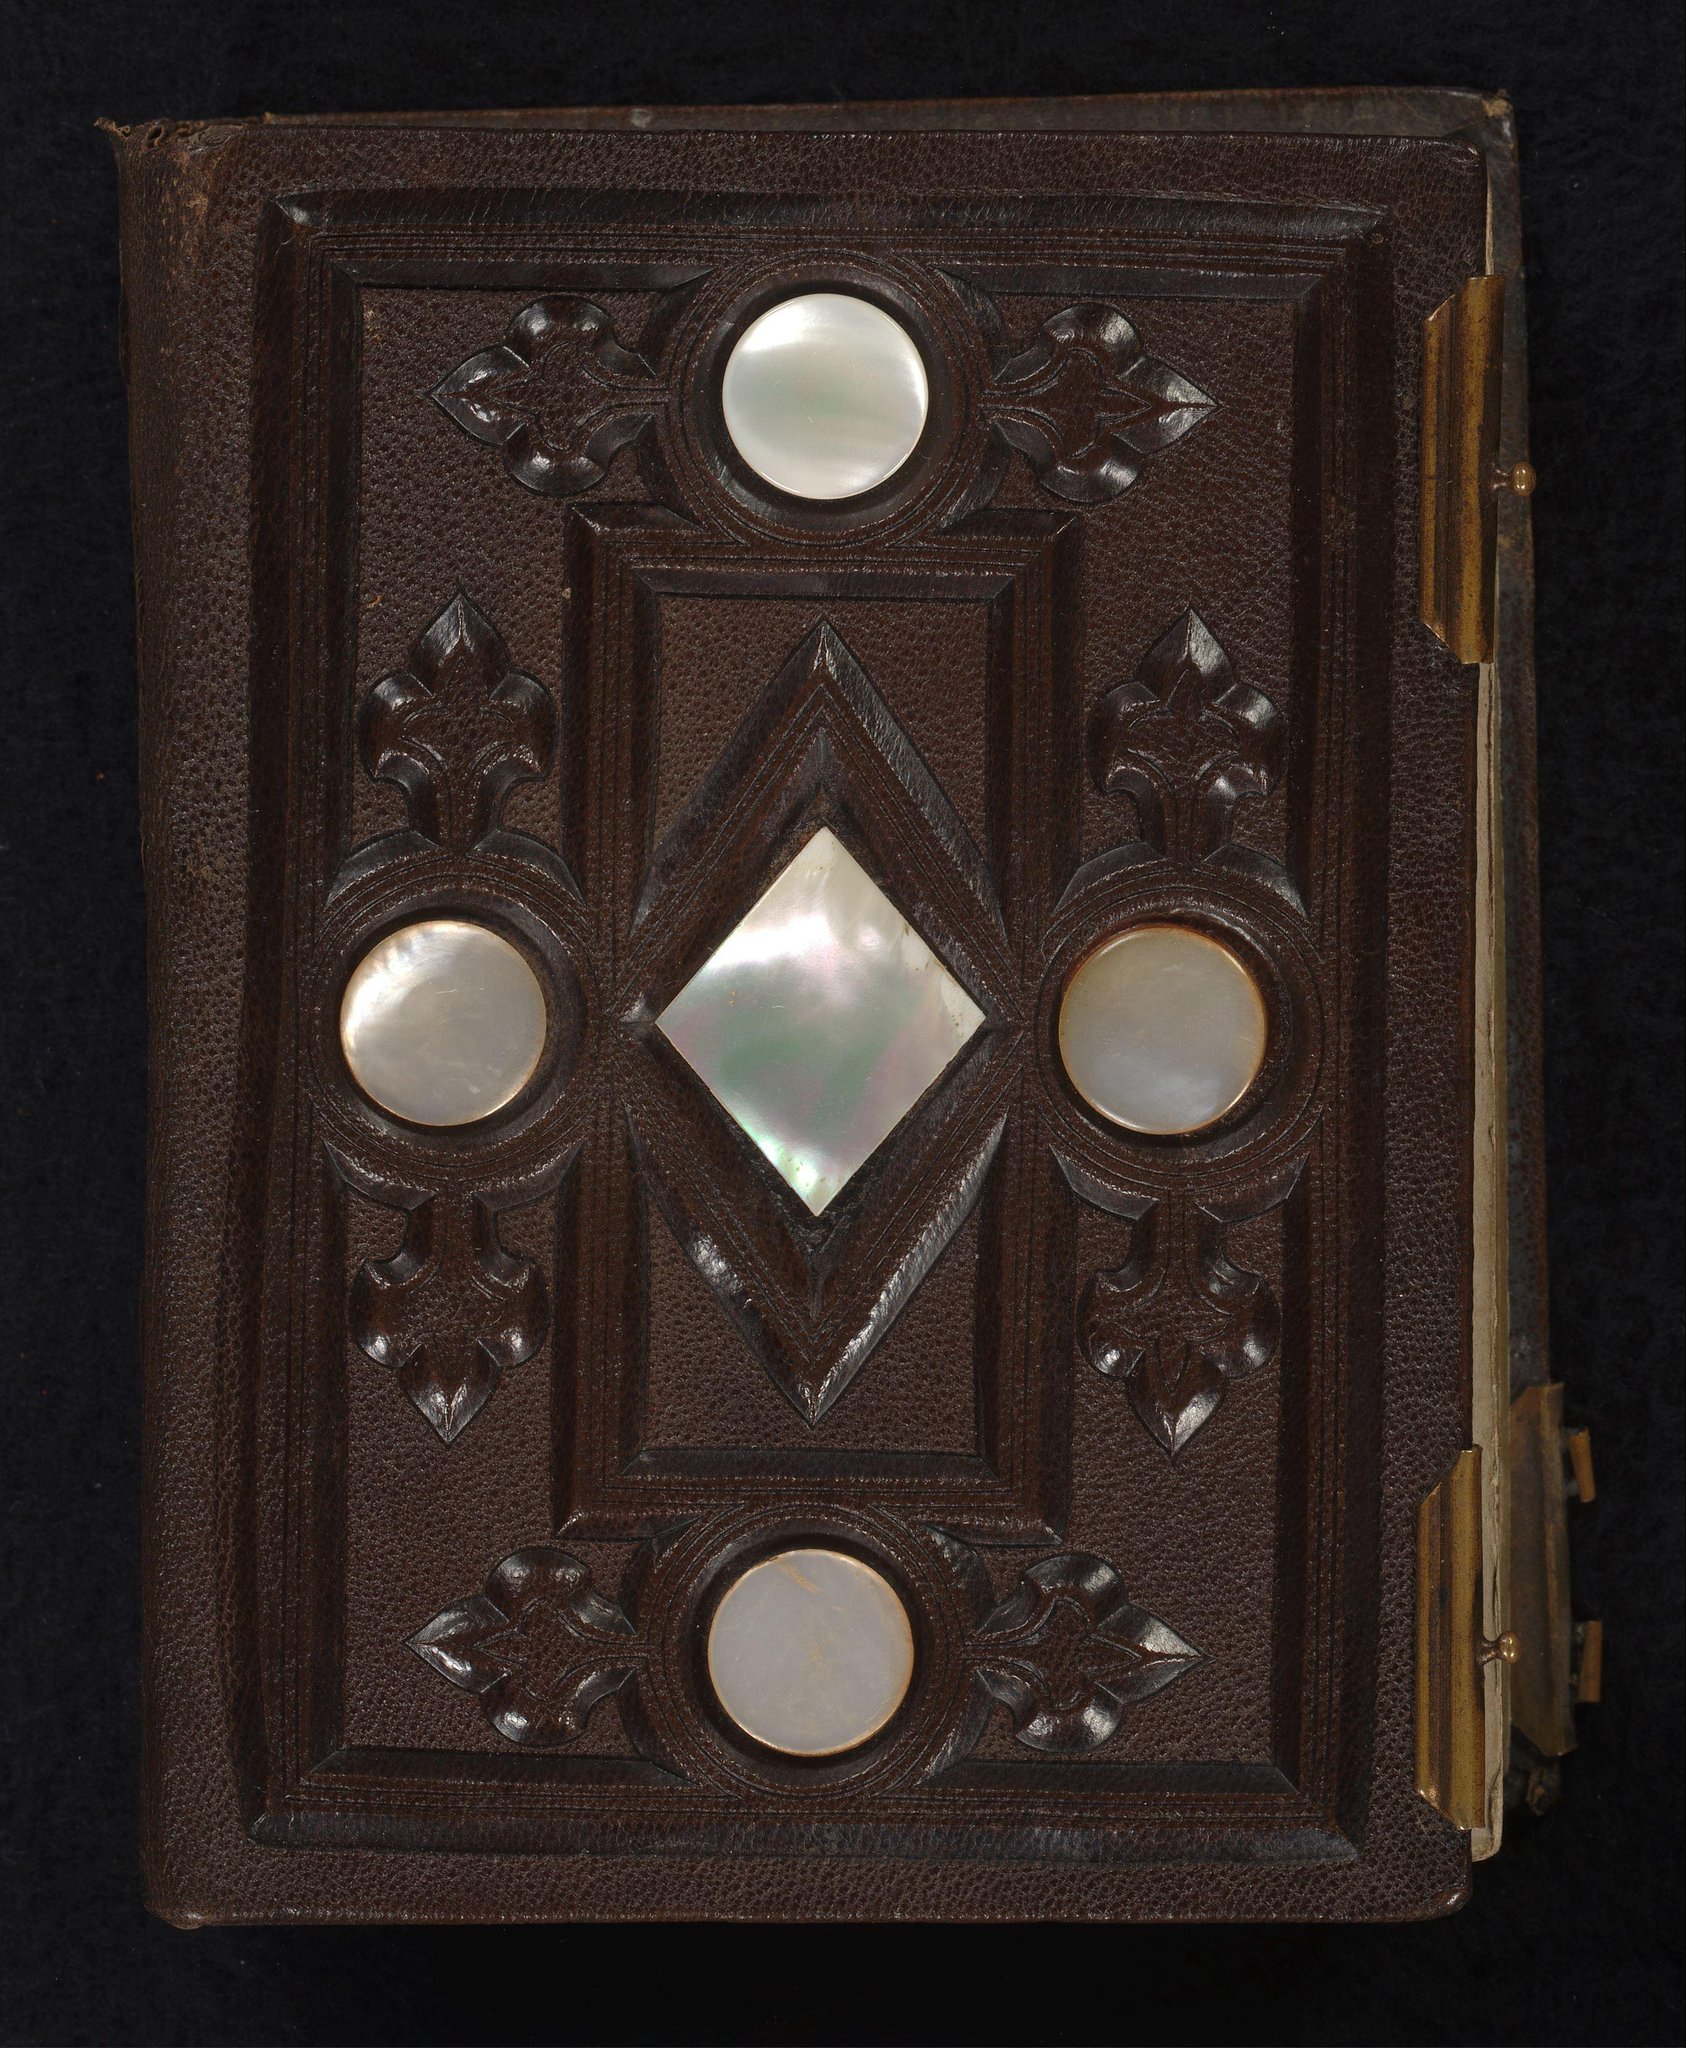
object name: photograph album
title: Engels en Schots fotoalbum met 36 foto's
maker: Anonymous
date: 1860-1900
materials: cardboard, leather, metal, mother of pearl, paper, photographic support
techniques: albumen print, ferrotyping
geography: united kingdom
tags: historical persons - bb - woman, child, historical persons, villa, united kingdom, glasgow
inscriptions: collector's mark: ‘DIENST/ VERSPREIDE/ RIJKSKOLLEKTIES/ (...) A 757’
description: Fotoalbum met in totaal 36 foto's op 48 pagina's. Het album bevat 35 cartes-de-visite en een ferrotypie in met gouden lijnen omkaderde passe-partouts. Iedere pagina bevat 1 passe-partout, maar niet alle passe-partouts in het album zijn gevuld. Afgebeeld zijn portretten van onbekende mannen, vrouwen en kinderen en een gezicht op een landhuis. De foto's zijn gemaakt door verschillende fotografen uit het Verenigd Koninkrijk. Van 8 foto's is de fotograaf anoniem.